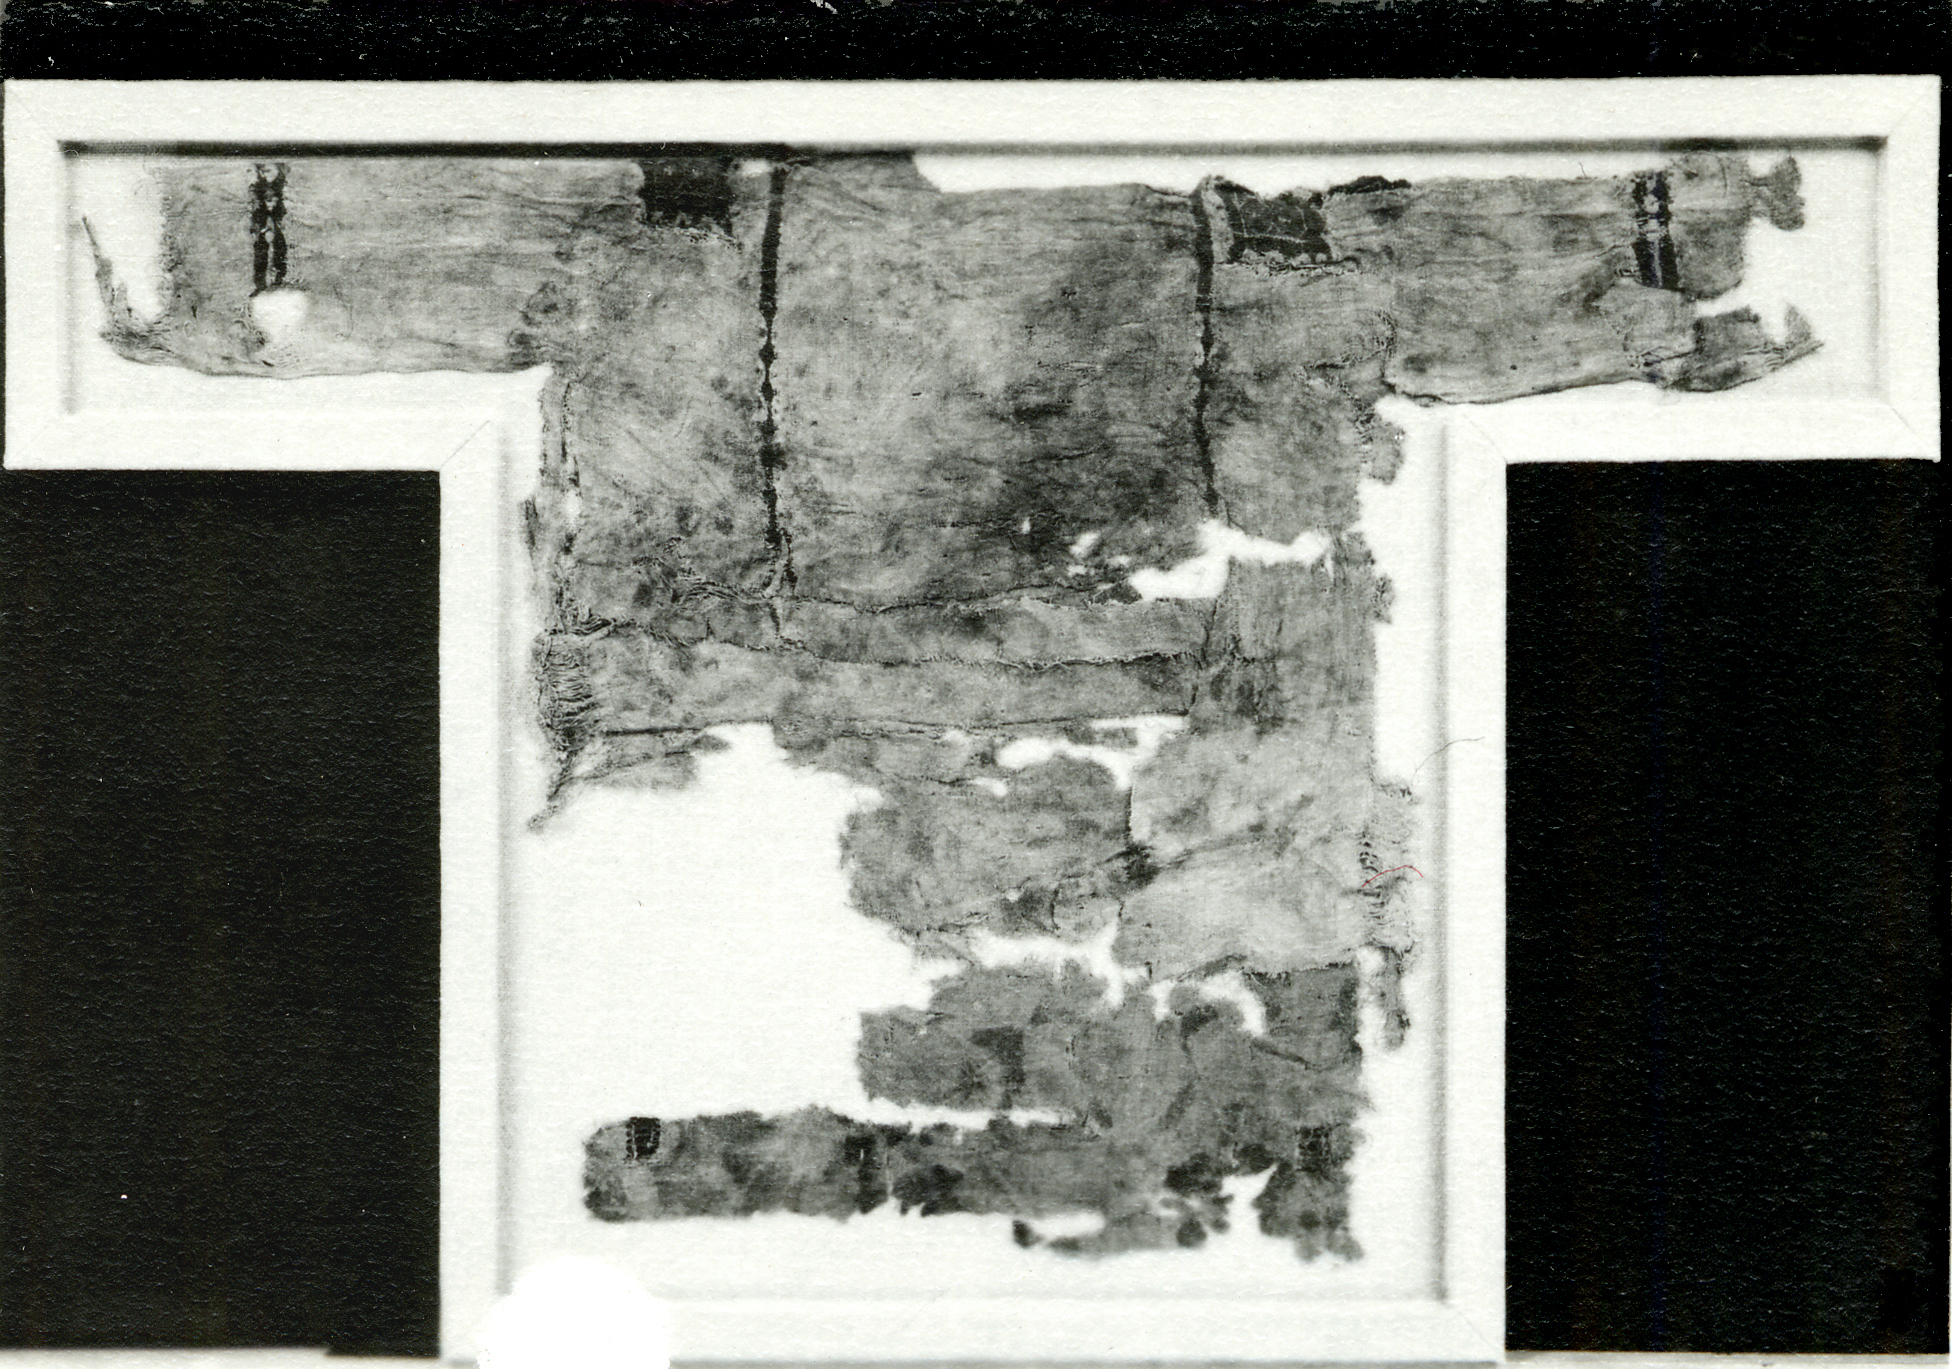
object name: fragment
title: Dress Fragments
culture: coptic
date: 301-400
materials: linen, wool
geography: egypt